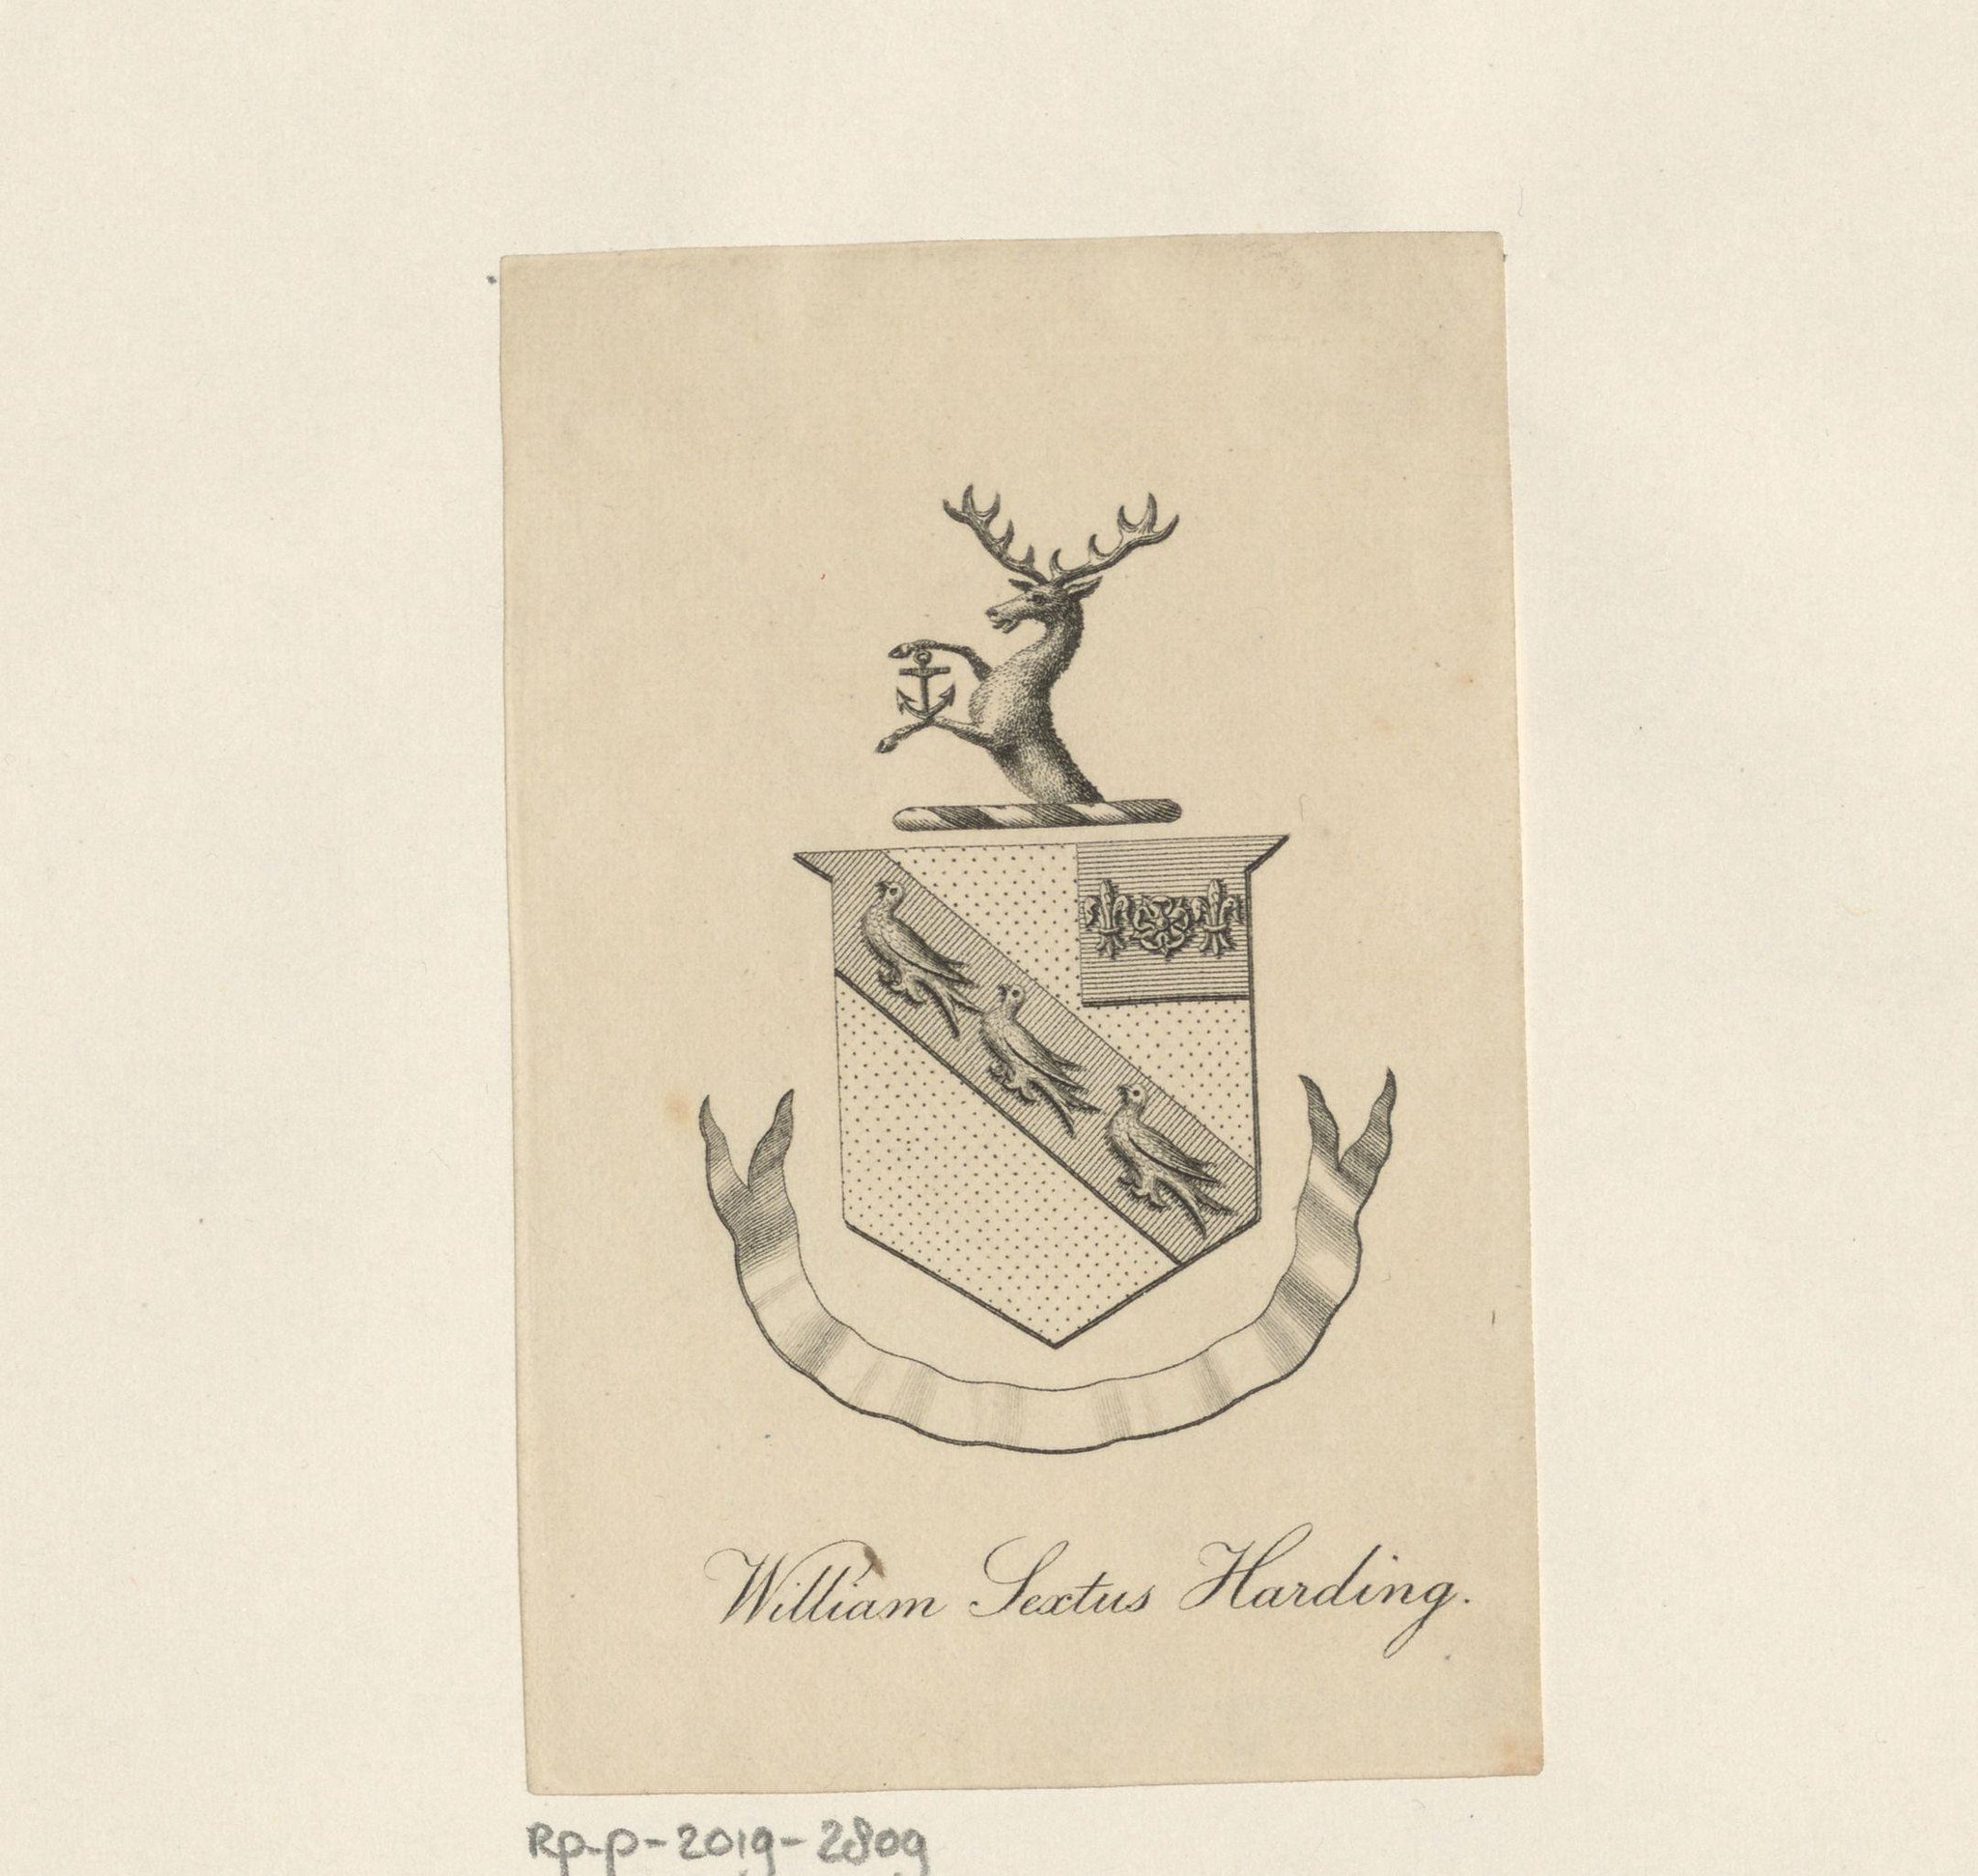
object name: bookplate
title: Ex libris van William Sextus Harding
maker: Anonymous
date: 1816-1896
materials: paper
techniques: engraving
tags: armorial bearing, heraldry